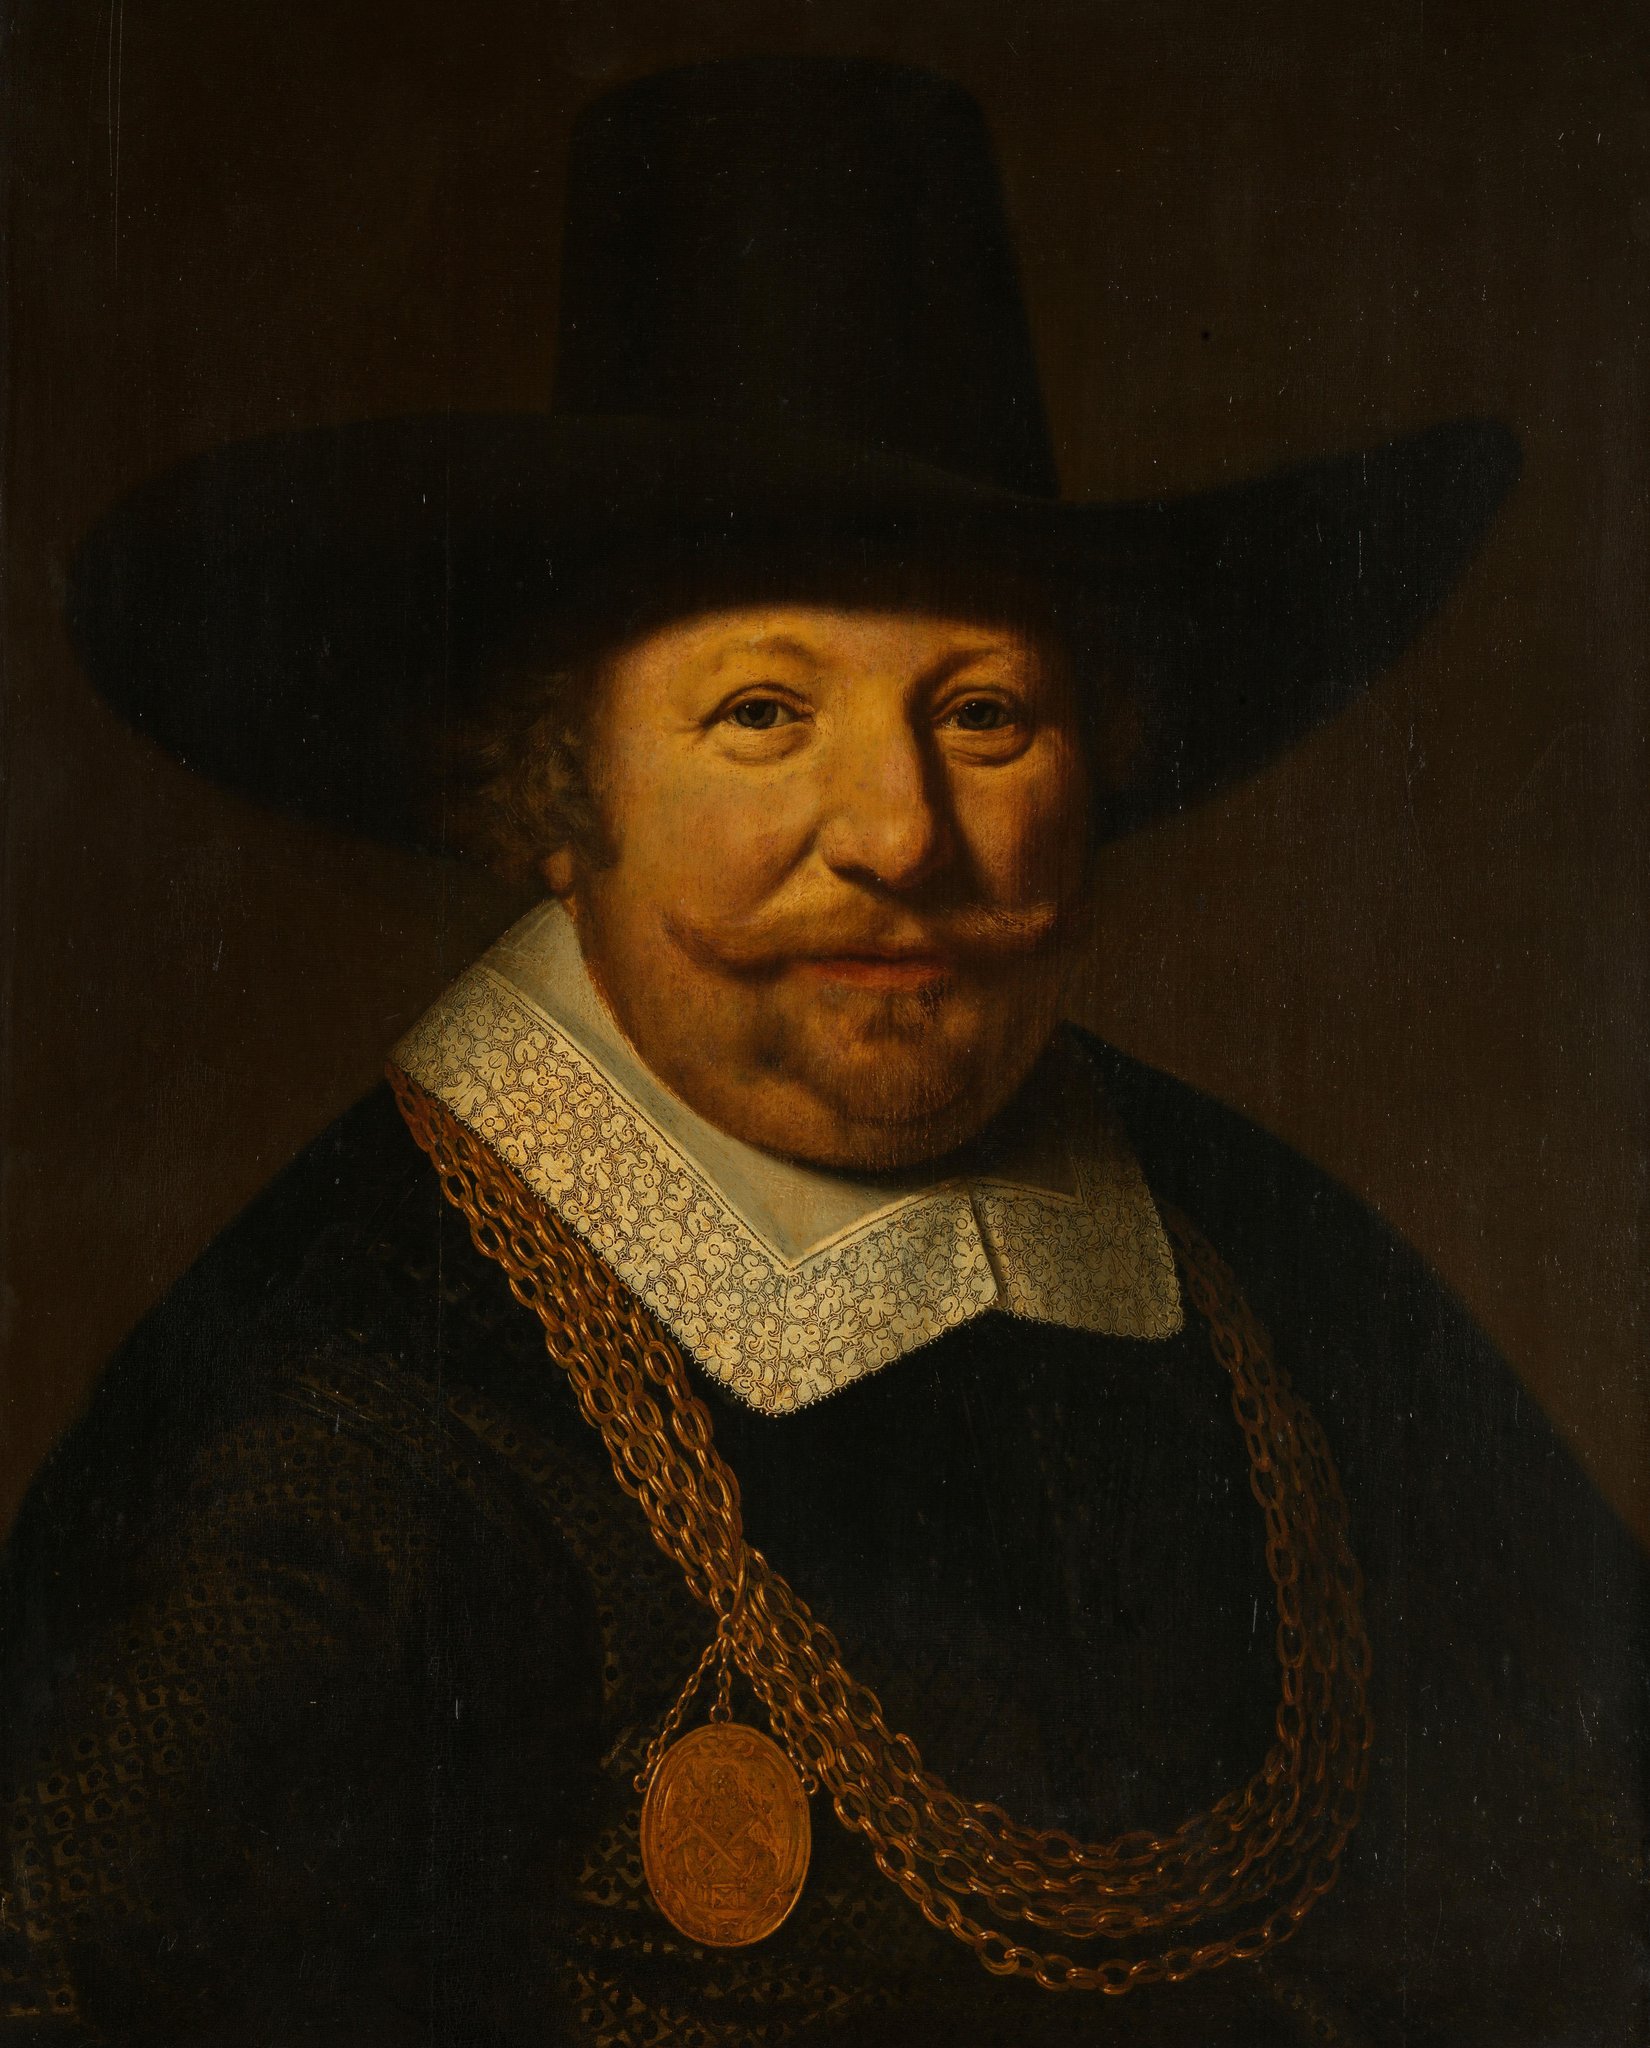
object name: painting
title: Portrait of Joos van Trappen, called Banckert, Vice-Admiral of Zeeland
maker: Anonymous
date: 1640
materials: canvas, oil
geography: netherlands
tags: flushing, historical persons, commander-in-chief, admiral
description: Portret van Joos van Trappen (1599-1647), genoemd Banckers, vice-admiraal van Zeeland. Buste en face, om de hals een ketting met een medaillon ontvangen van de Generale Staten na de slag bij Duins (1639).